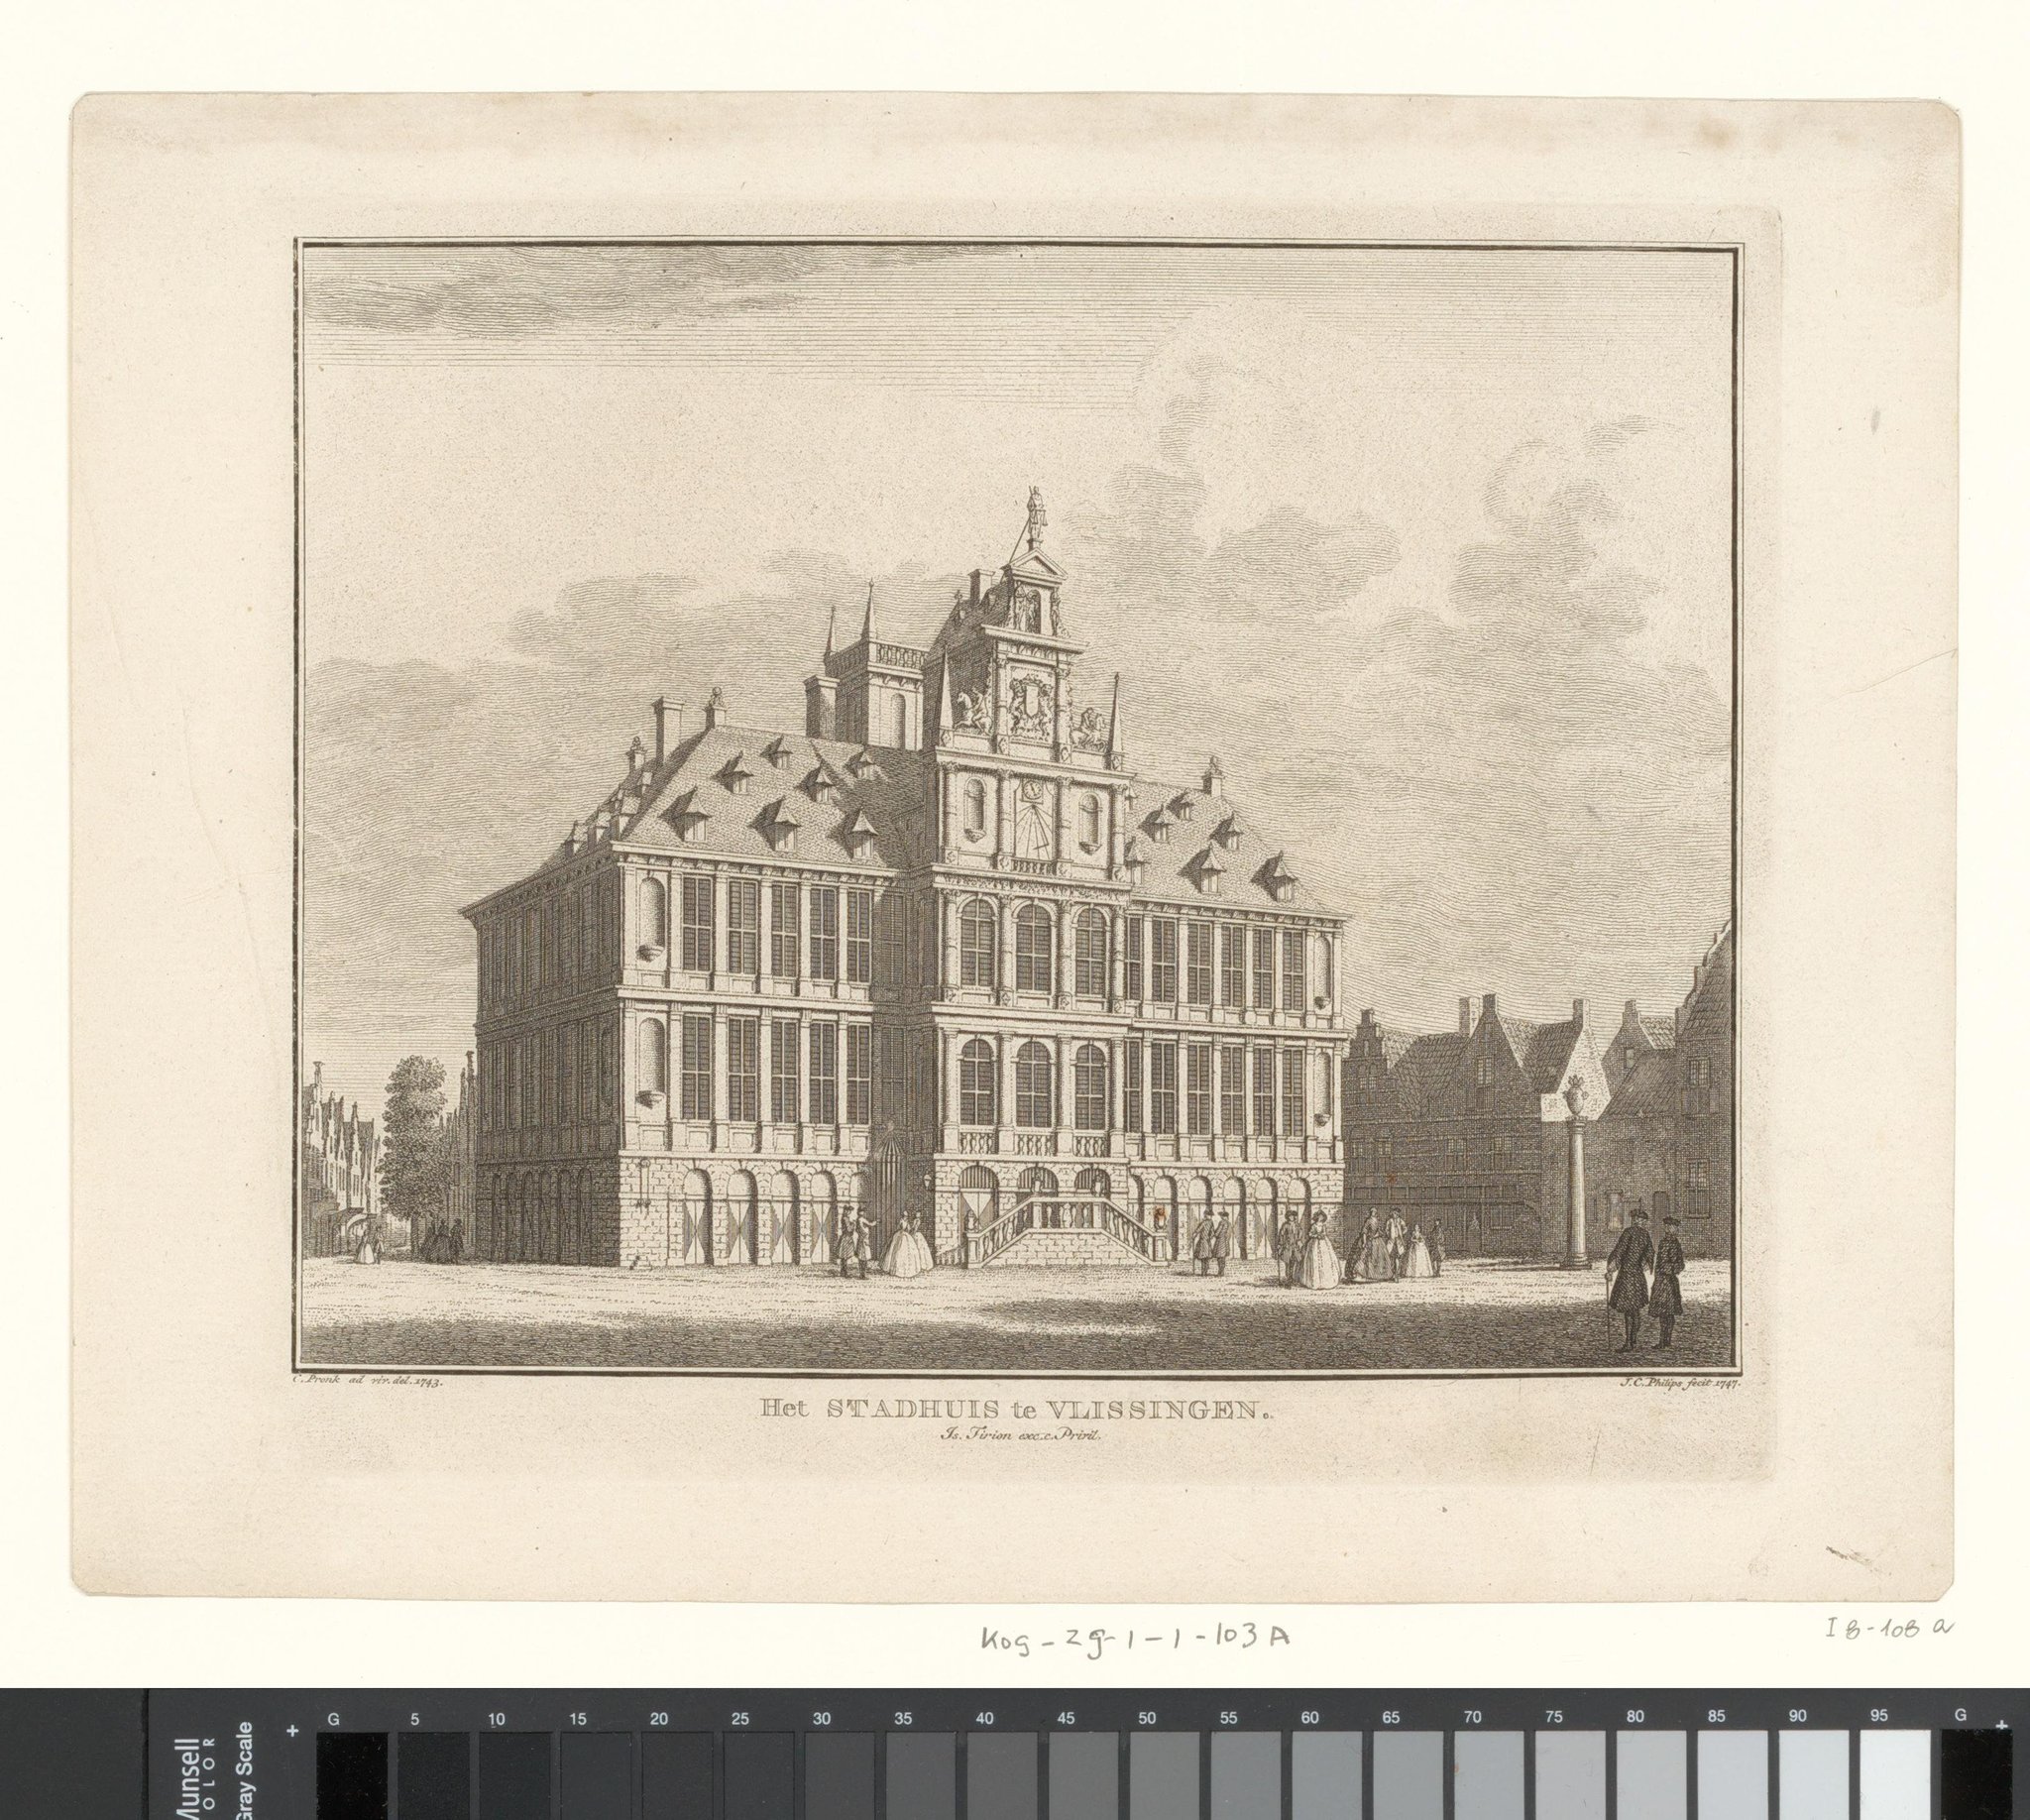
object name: print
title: Het Stadhuis te Vlissingen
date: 1747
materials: paper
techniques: etching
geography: amsterdam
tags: townhall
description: Gezicht op het Oude Stadhuis van Vlissingen, in de situatie omstreeks 1743. Onderwerpsrubrieken binnen de Atlas Zeden en Gewoonten: Regeering, Stadhuizen (T-Z).